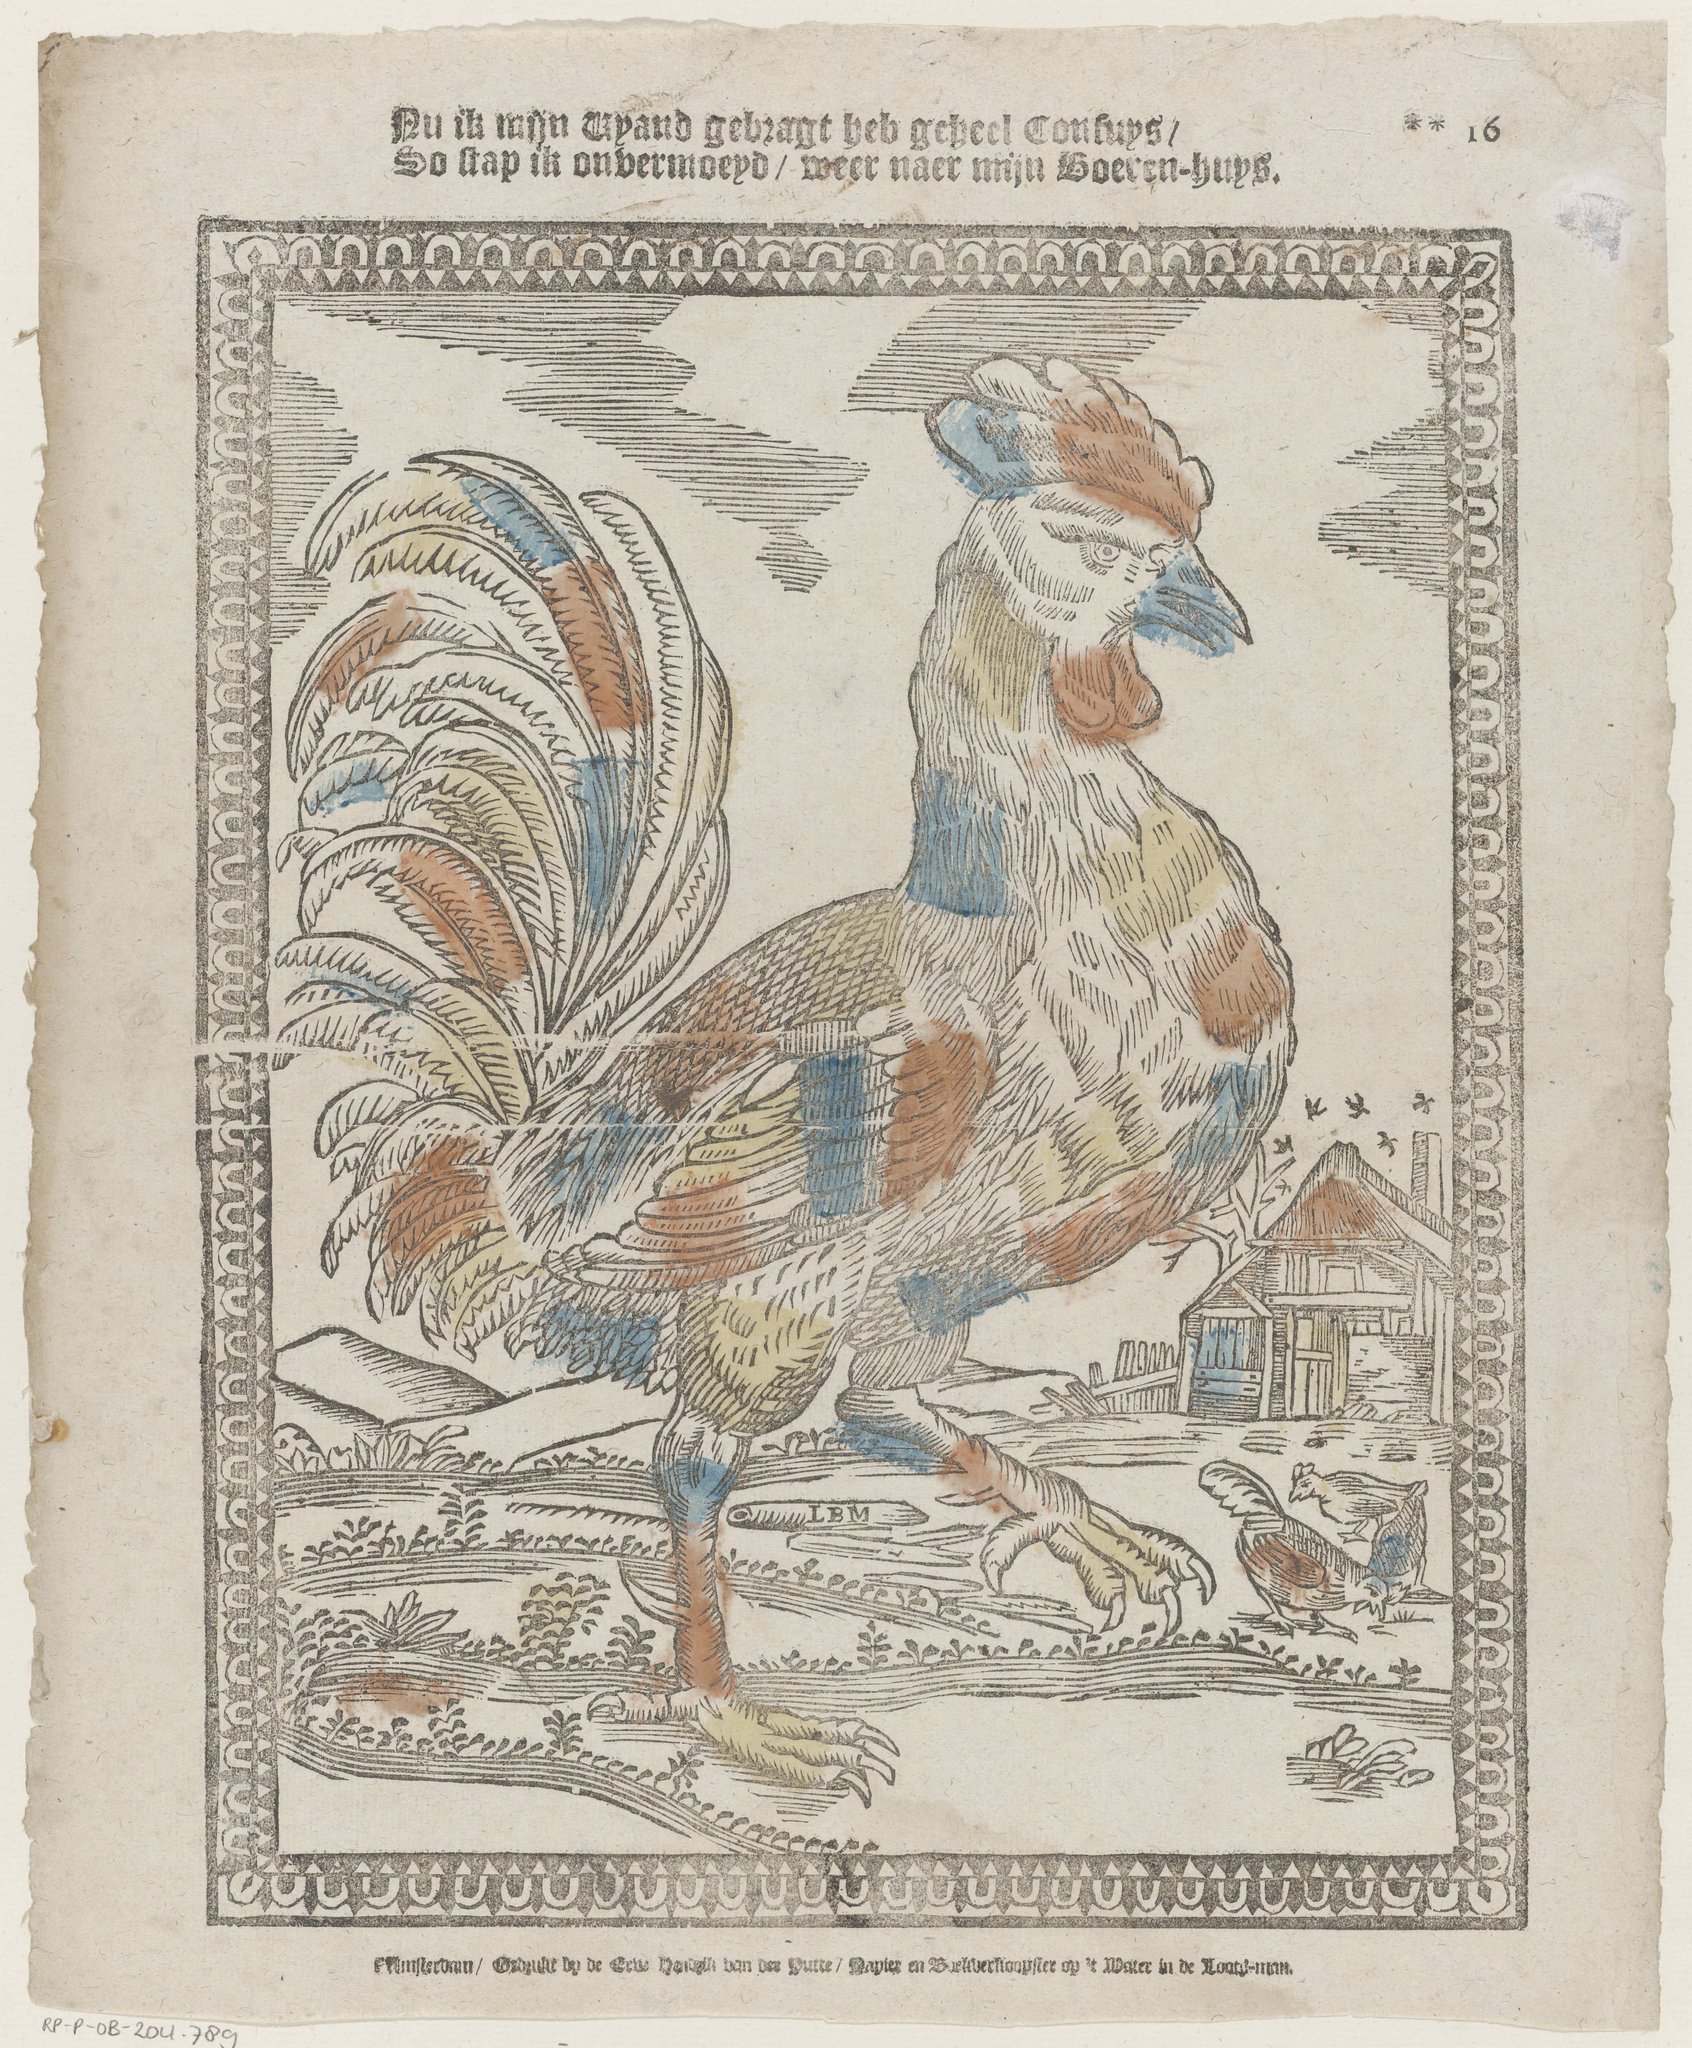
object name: print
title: Nu ik mijn vijand heb gemaakt geheel confuys / So stap ik onvermoeyd / weer naar mijn boeren-huys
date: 1767-1793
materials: paper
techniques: colour, letterpress printing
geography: amsterdam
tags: fowl (cock, hen, chicken, etc.)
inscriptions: collector's mark: Lugt 2760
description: Blad met een grote voorstelling van een haan. Op de achtergrond twee kippen en een boerderij. De voorstelling is gevat in een sierlijst. Genummerd rechtsboven: **16.